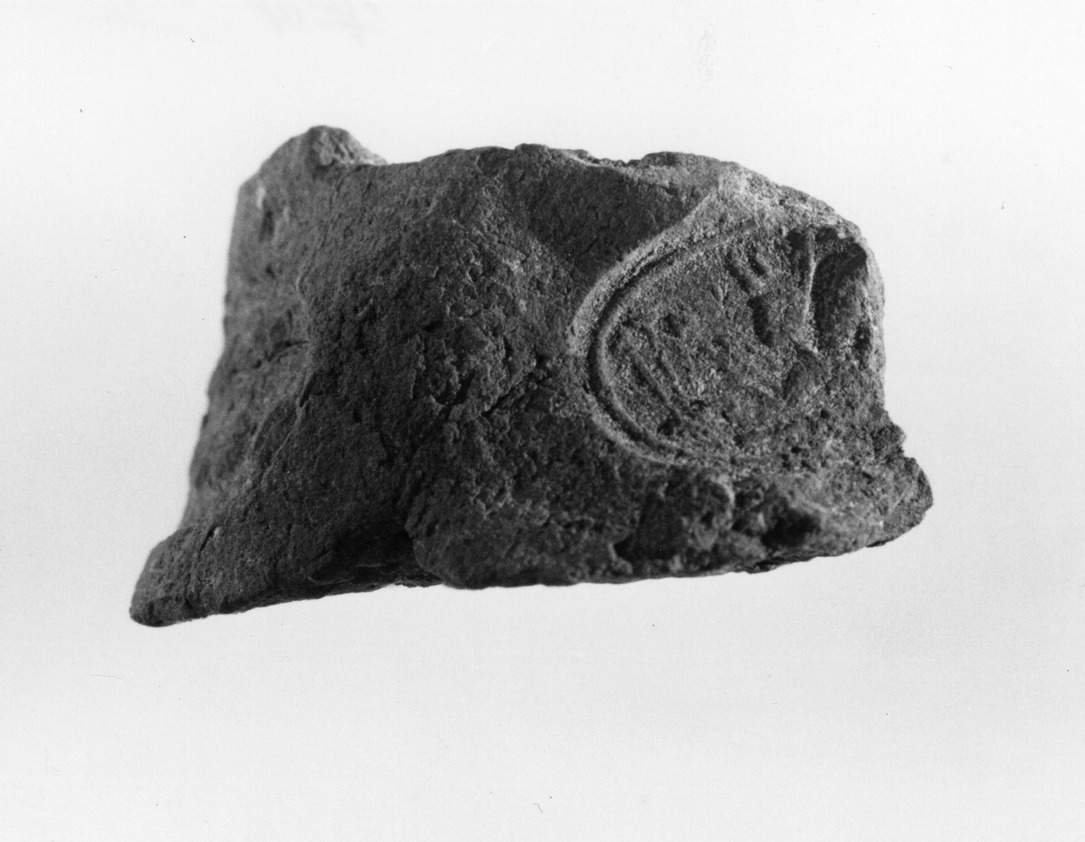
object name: sealing, amenhotep iii, nebmaatre, tiye, female sphinx,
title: Document Sealing With Multiple Seal Impressions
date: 1390-1352 BCE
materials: mud